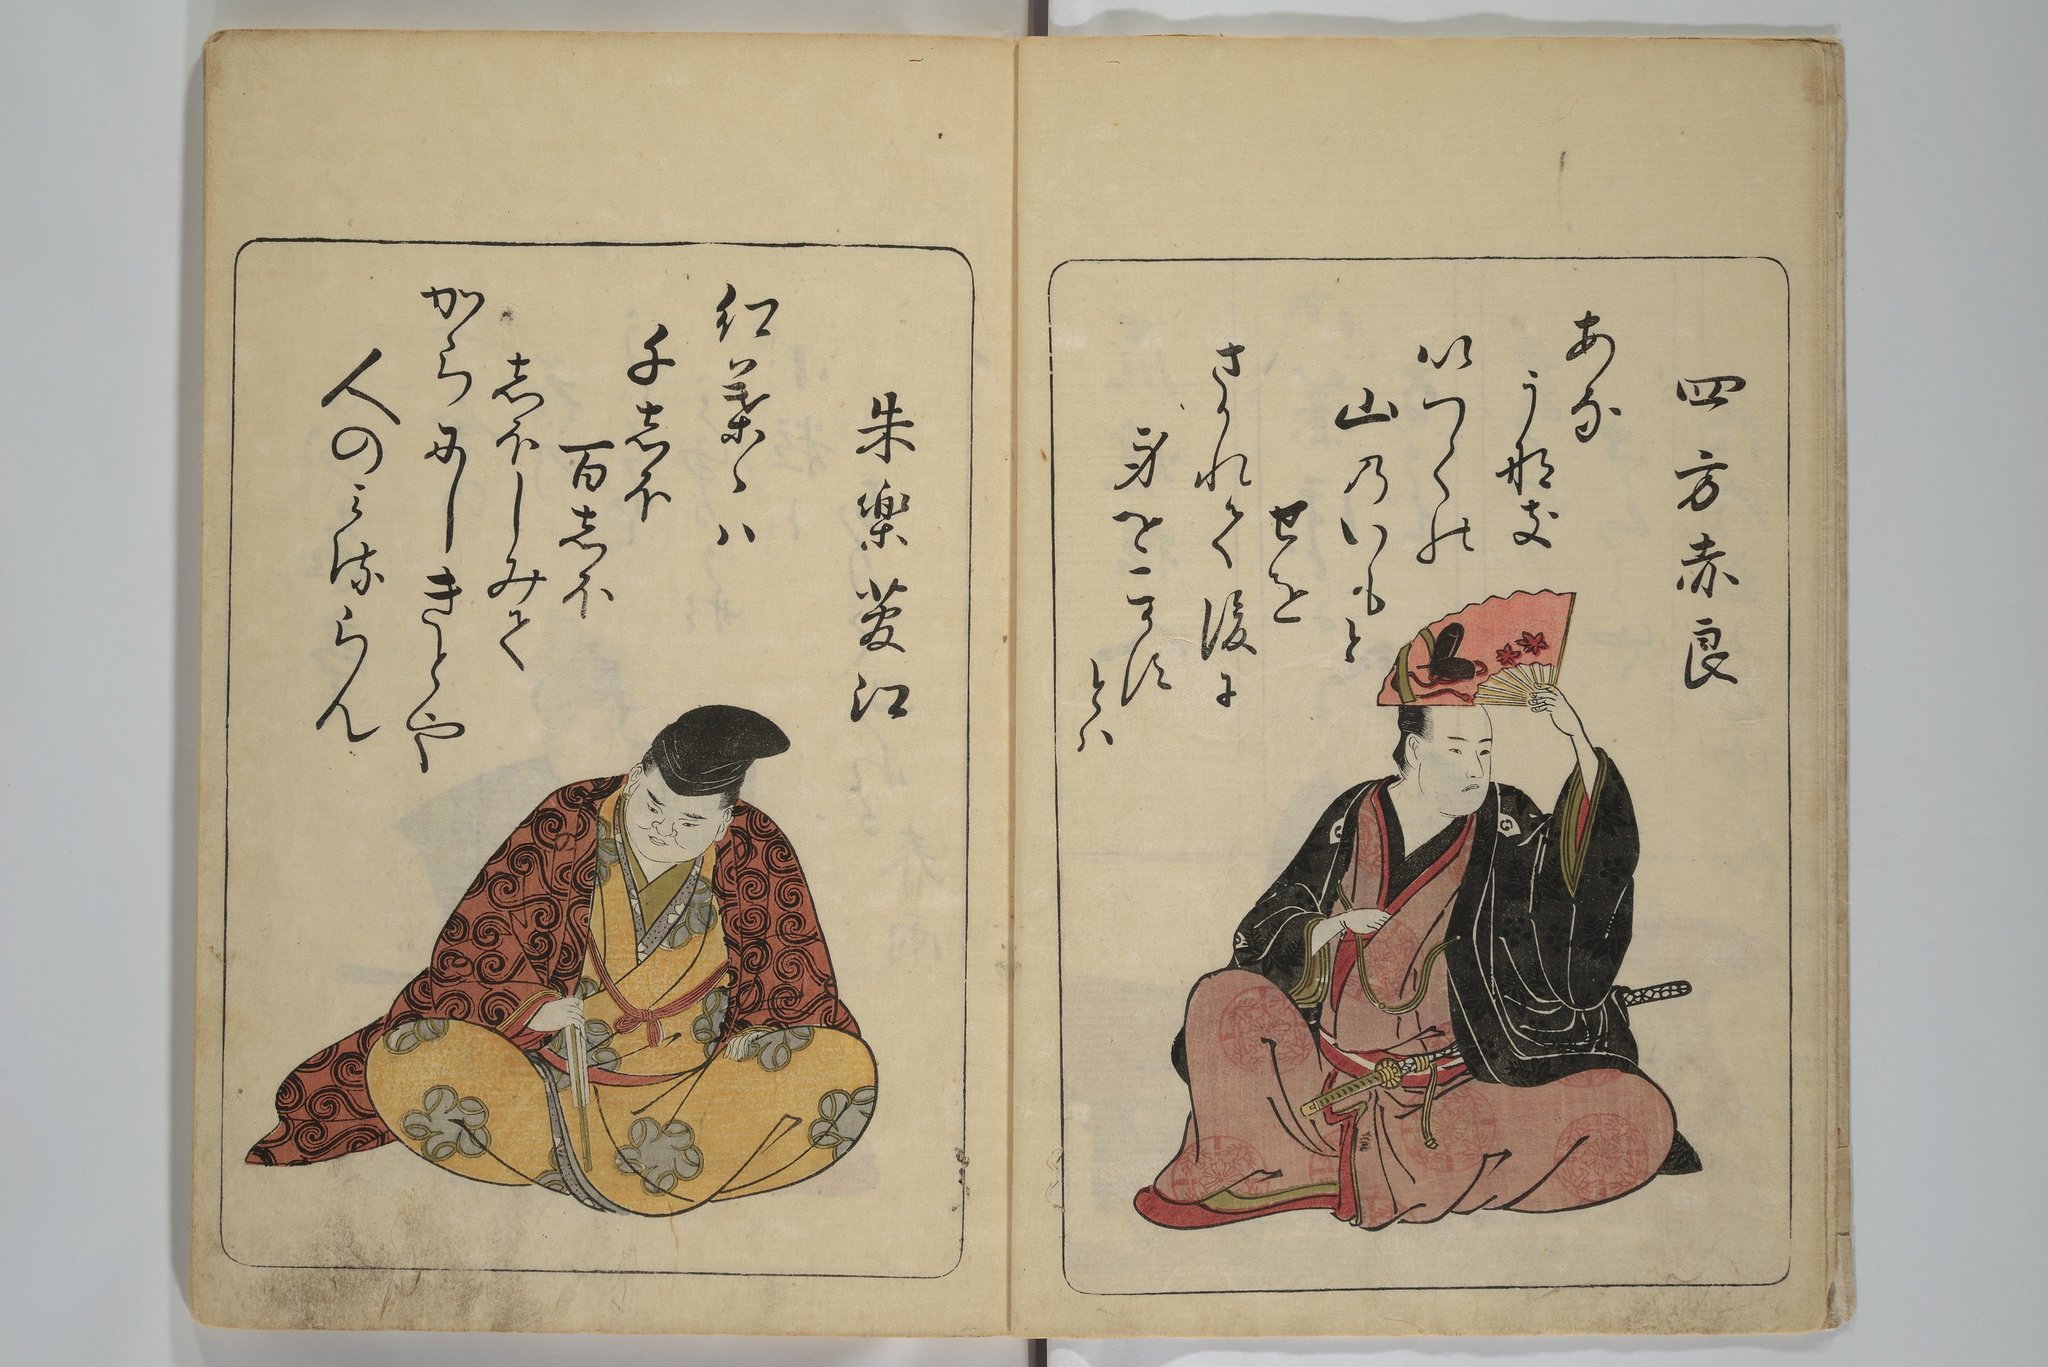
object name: illustrated book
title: Newly Selected Fifty Poets of the Tenmei Era, One Poem Each (Tenmei shinsen gojūnin isshu) 天明新鐫五十人一首; 吾妻曲狂歌文庫(あずまぶり)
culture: japanese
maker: kitao masanobu (santō kyōden) 北尾政演 (山東京伝)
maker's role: artist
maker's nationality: japanese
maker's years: 1761-1816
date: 1786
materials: ink, paper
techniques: woodblock print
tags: poetry,men,poets